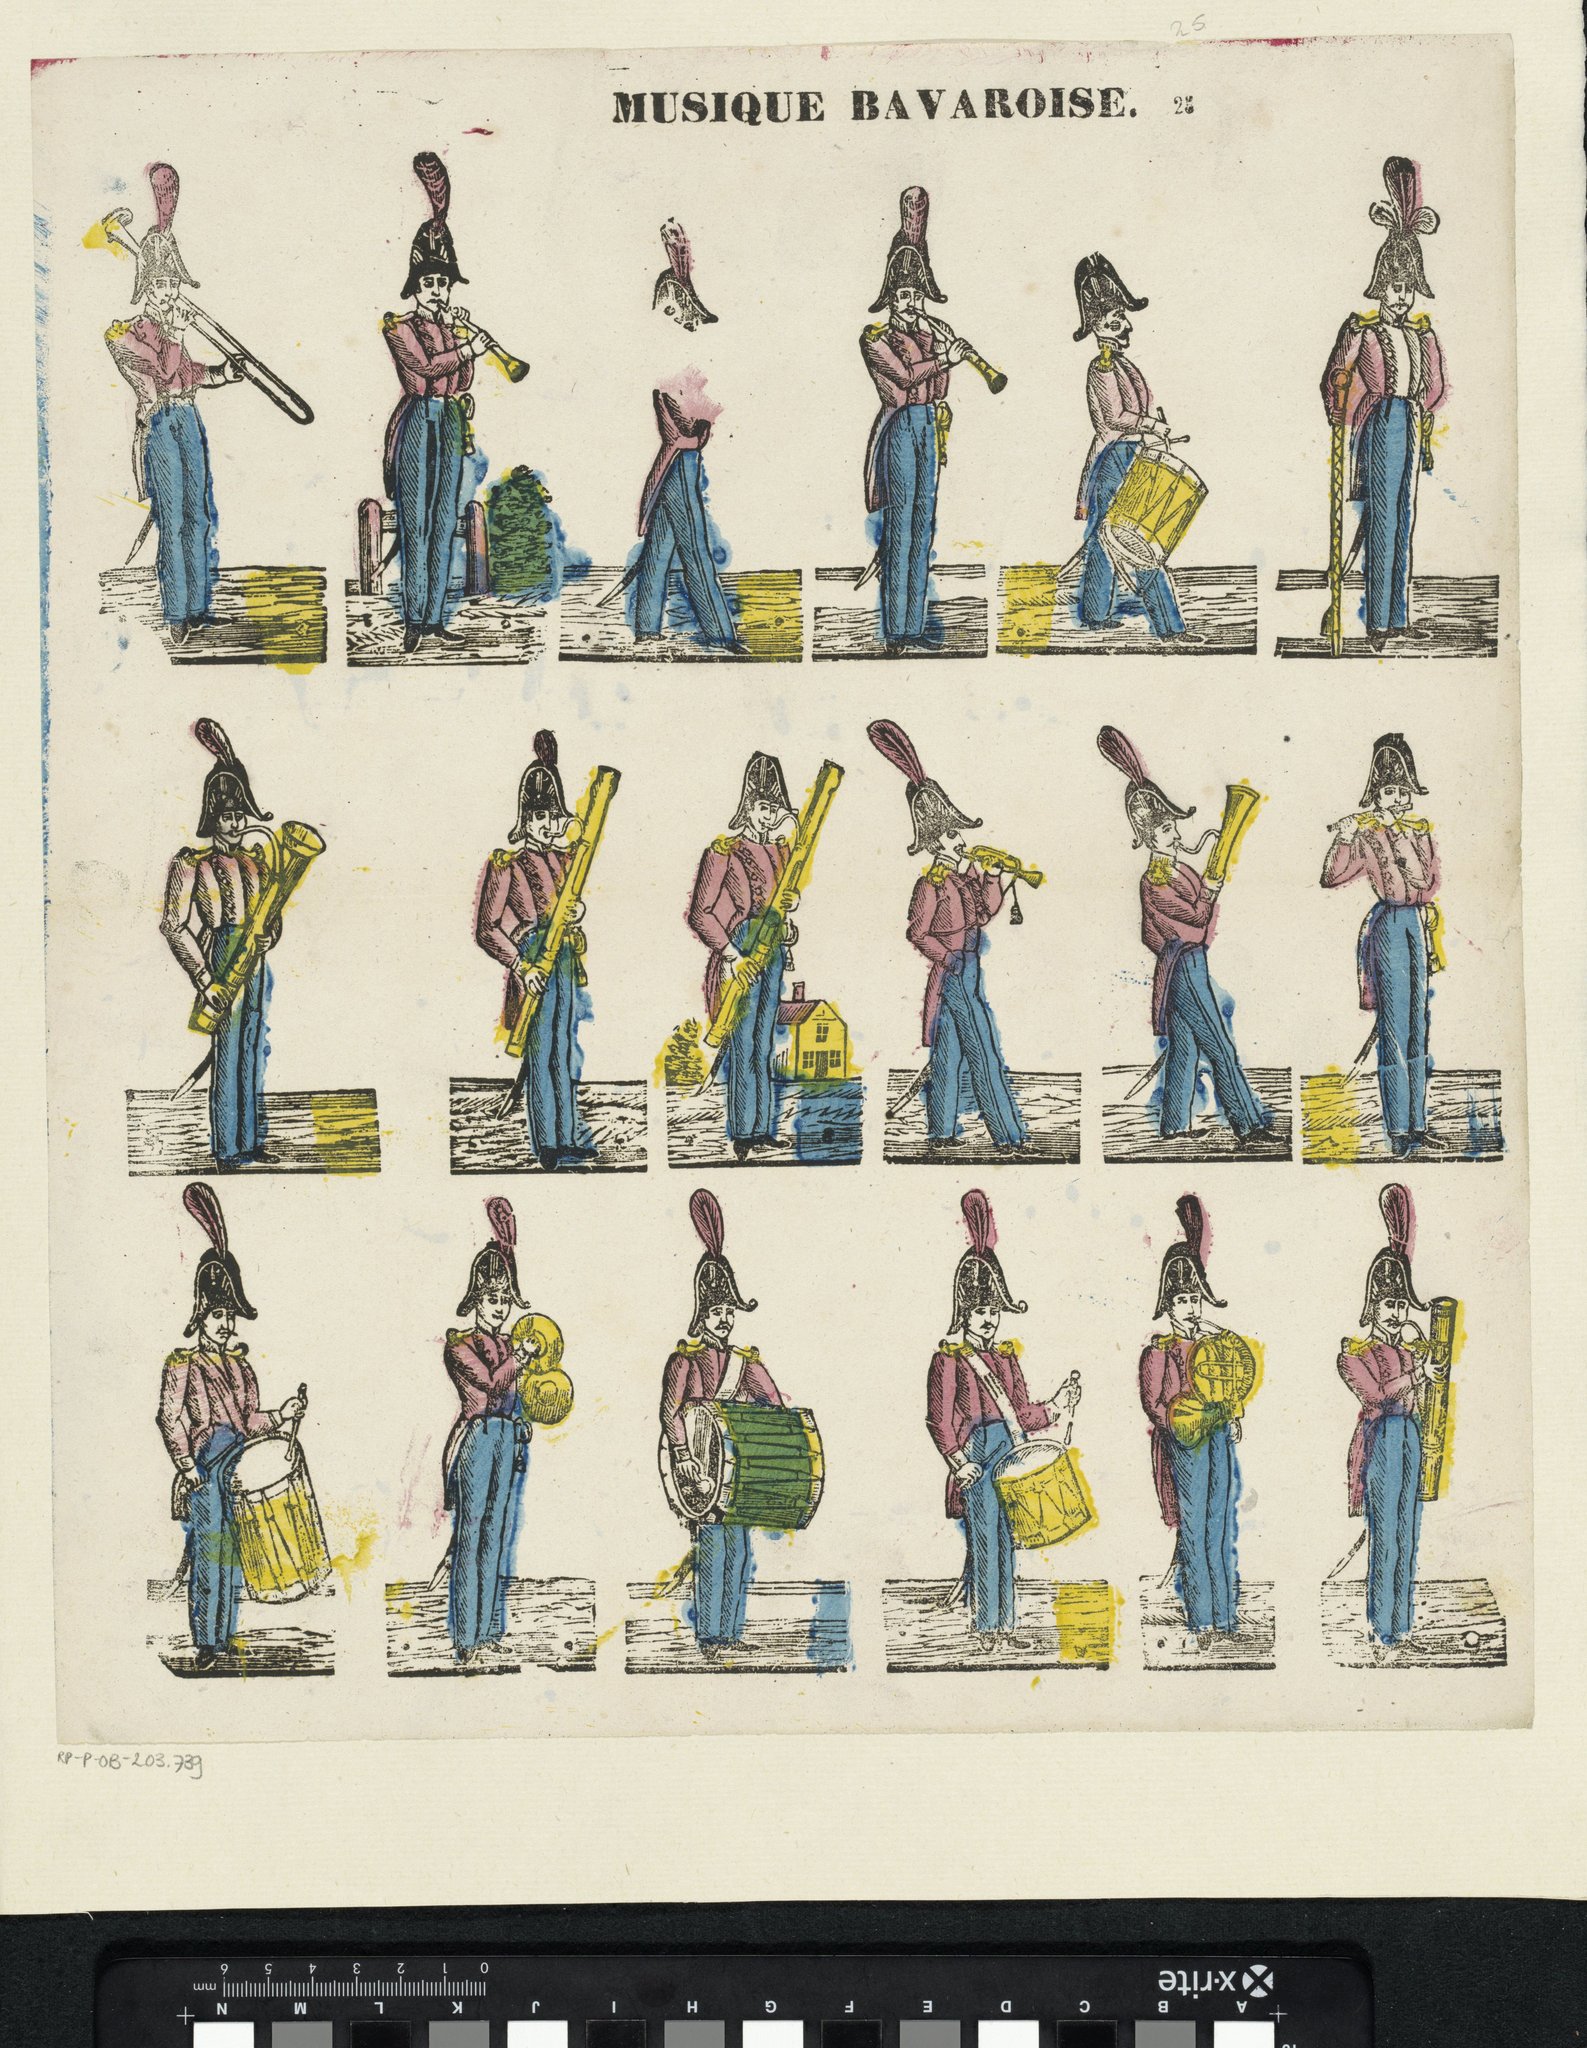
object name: print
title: Musique Bavaroise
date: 1827-1894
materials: paper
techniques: colour, letterpress printing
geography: schaarbeek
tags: military band, the soldier; the soldier's life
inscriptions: collector's mark: Lugt 2760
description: Blad met 18 voorstellingen van militairen met muziekinstrumenten. Genummerd midden boven: 25.